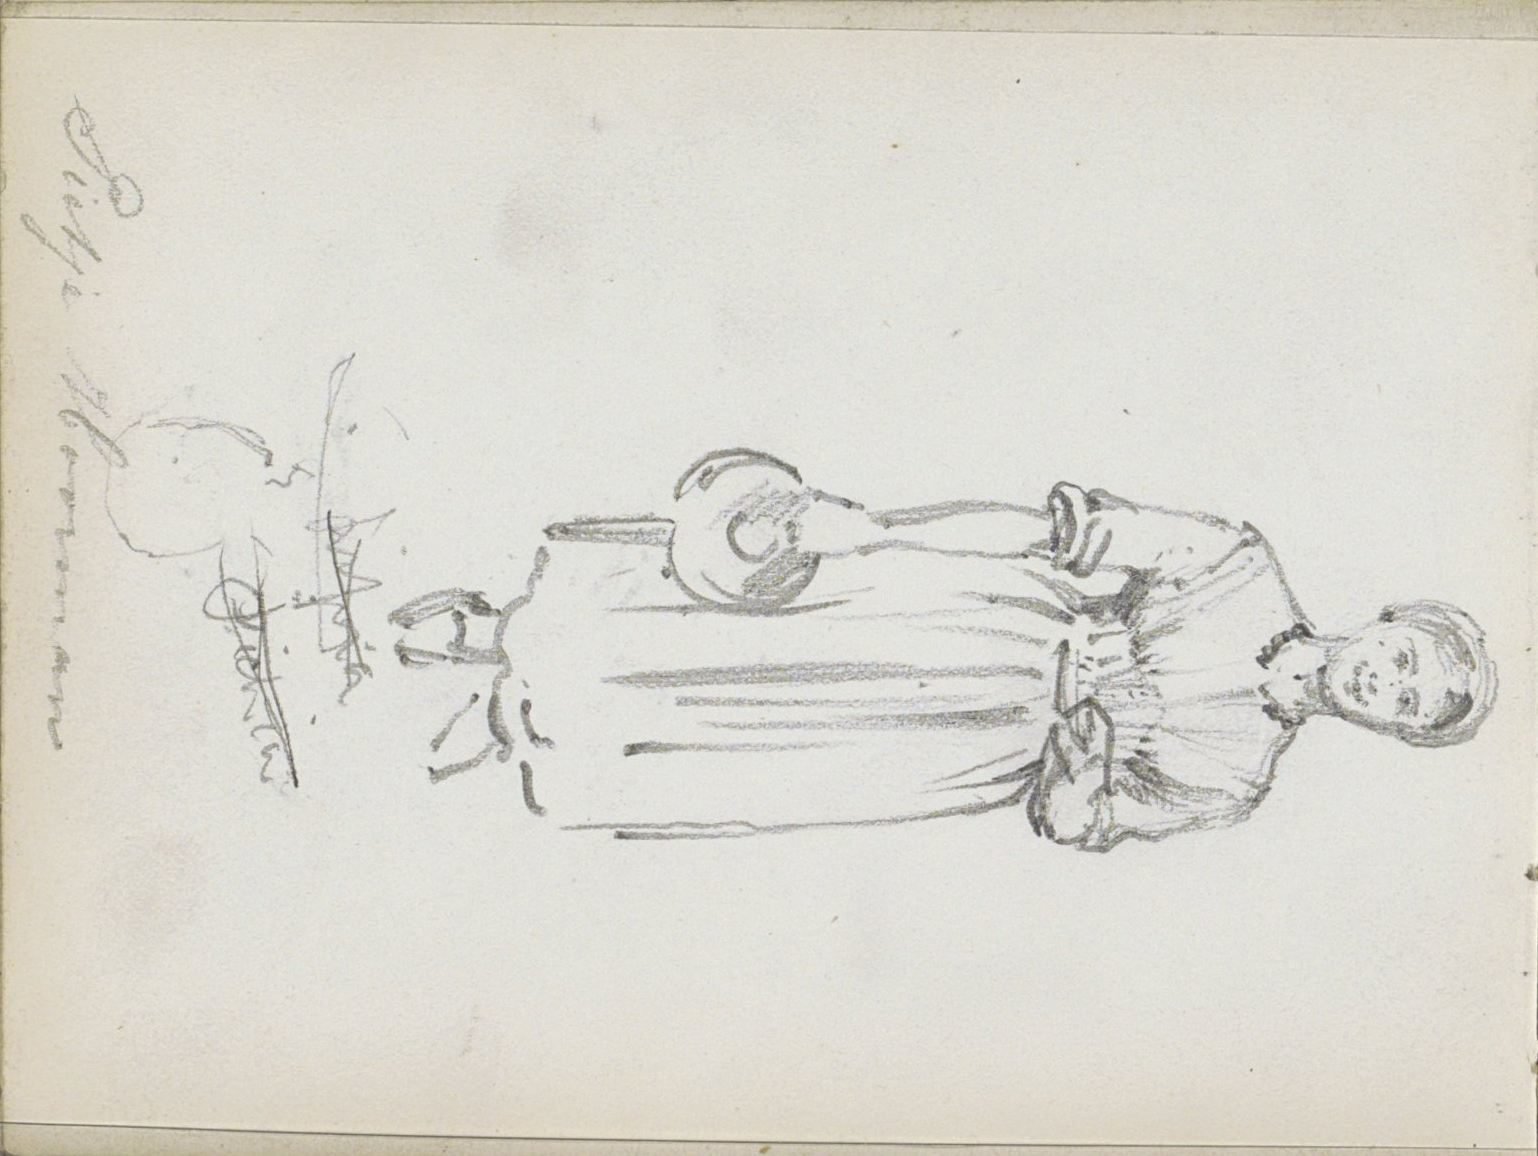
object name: sketchbook leaf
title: Portret van Pietje Hoorman in klederdracht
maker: george clausen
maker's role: draughtsman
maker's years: 1852-1912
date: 1874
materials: paper, pencil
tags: standing figure, adult woman, folk costume, regional costume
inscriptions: annotation: ‘Pietje Hoorman’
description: De vrouw houdt een voorwerp, vermoedelijk een hoed, in de rechterhand. Blad 26 verso uit een schetsboek met 37 bladen.